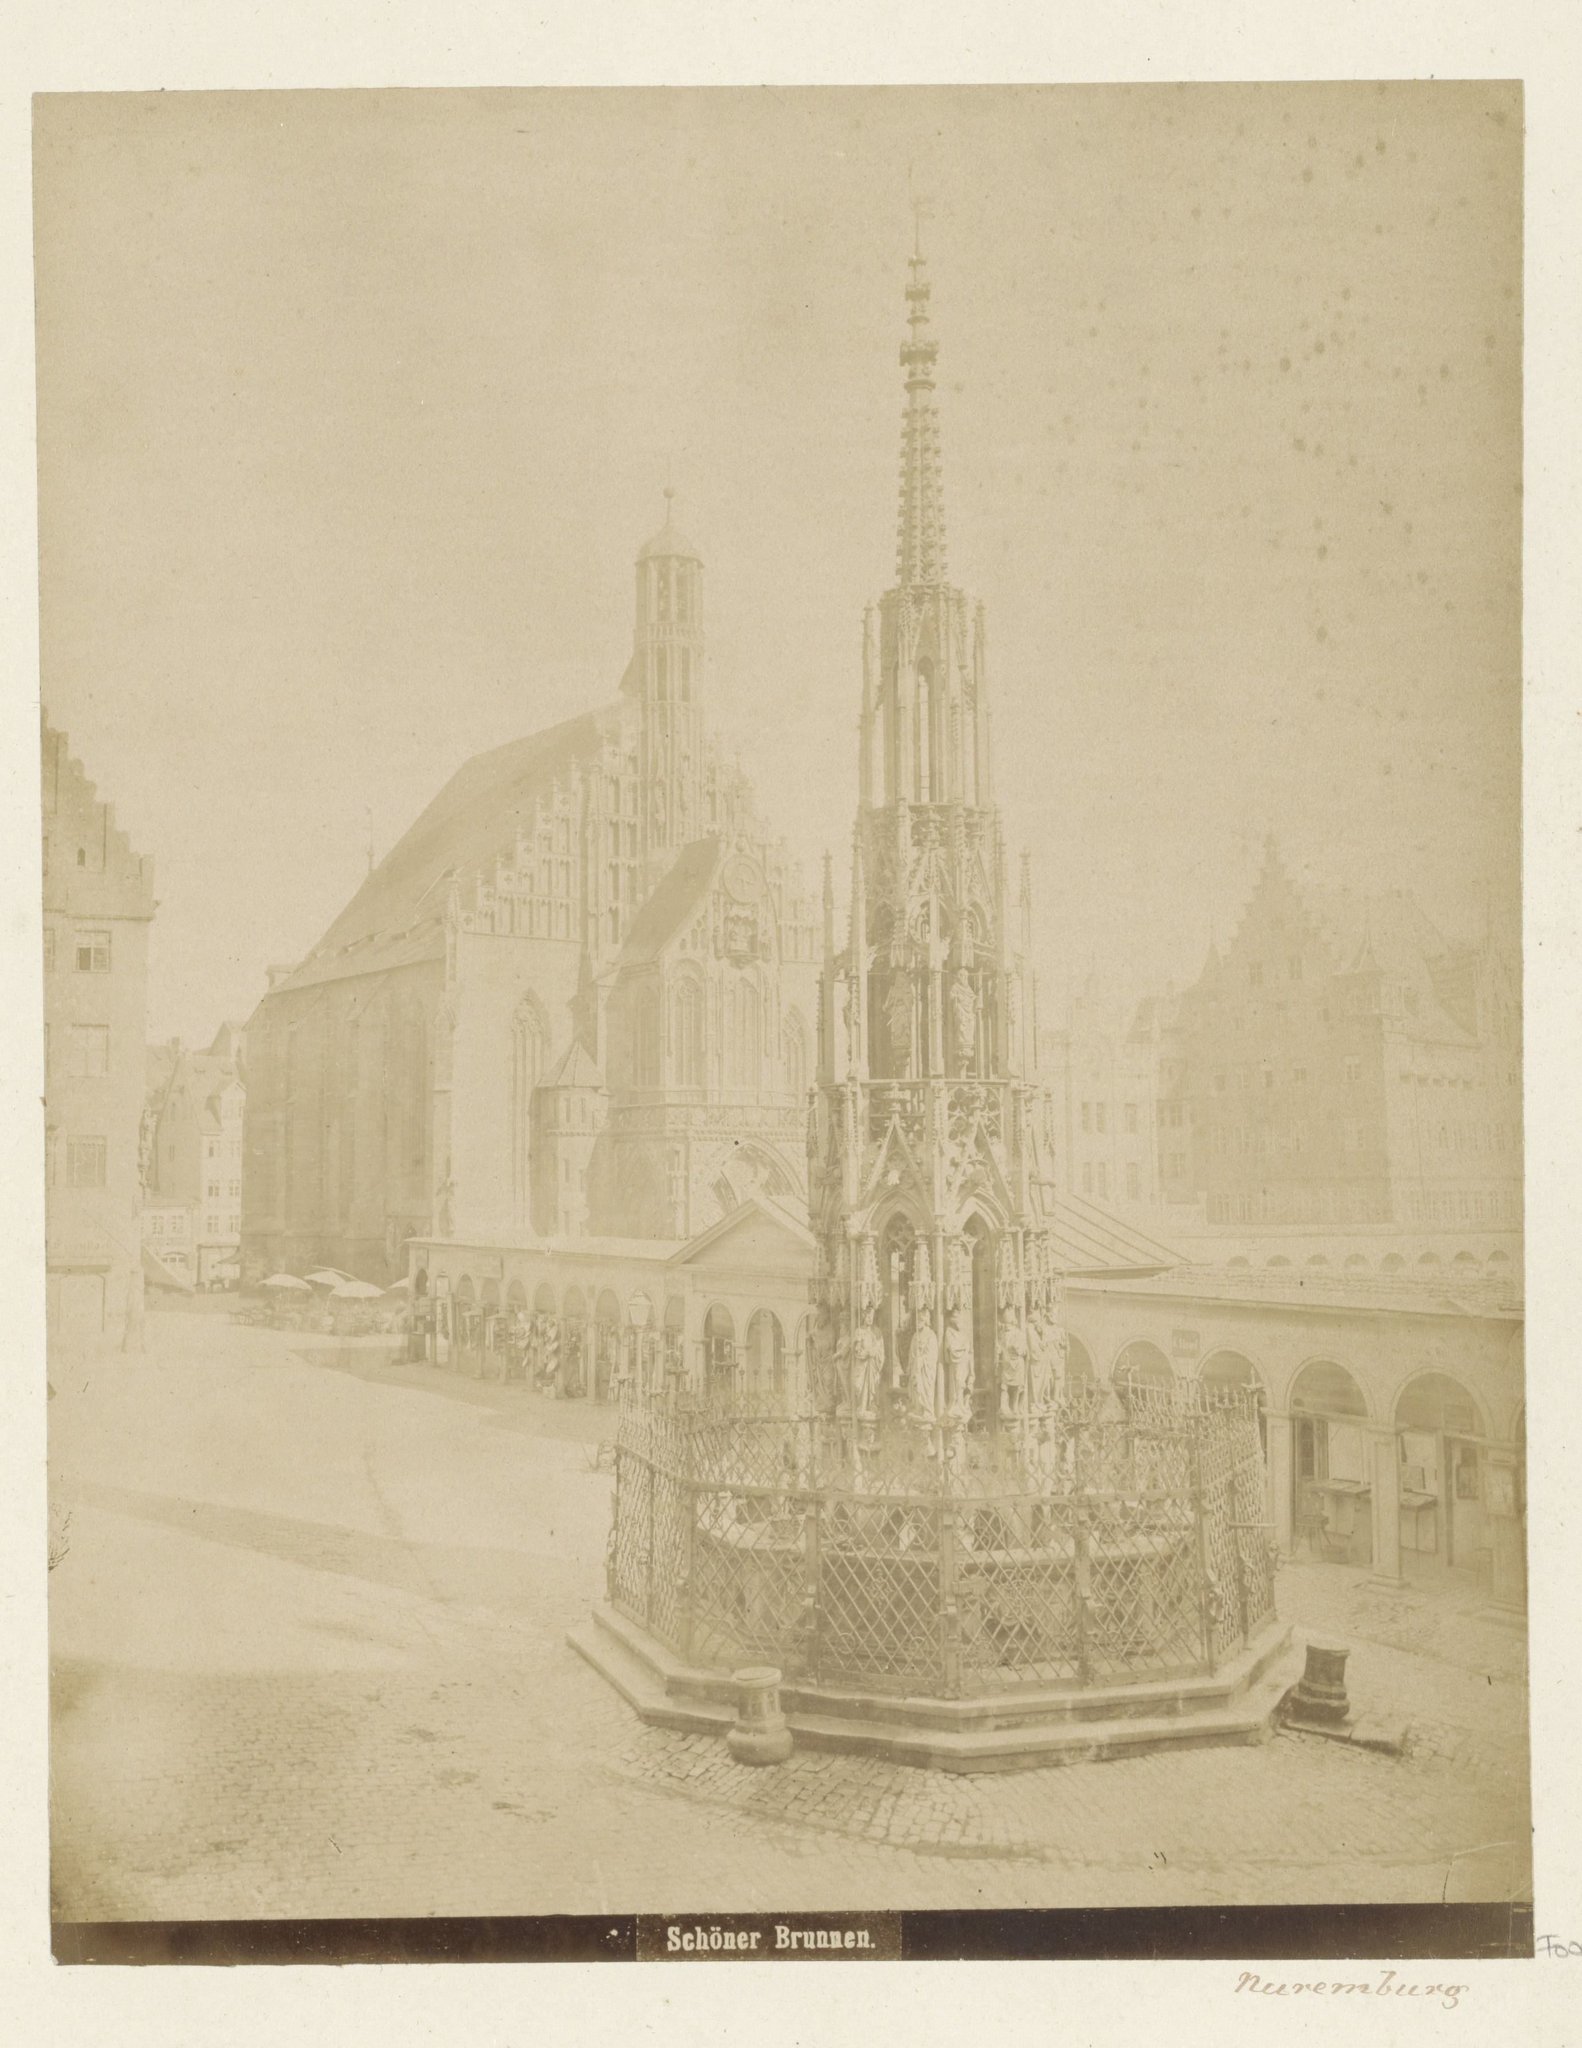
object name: photograph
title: Schöner Brunnen in Neurenberg met op de achtergrond de Onze-Lieve-Vrouwekerk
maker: Anonymous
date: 1860-1890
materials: paper, photographic support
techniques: albumen print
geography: nuremberg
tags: church (exterior), utilitarian, public pump or water fountain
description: Onderdeel van Reisalbum met foto's van Zwitserland, Oostenrijk, Italië en Duitsland.